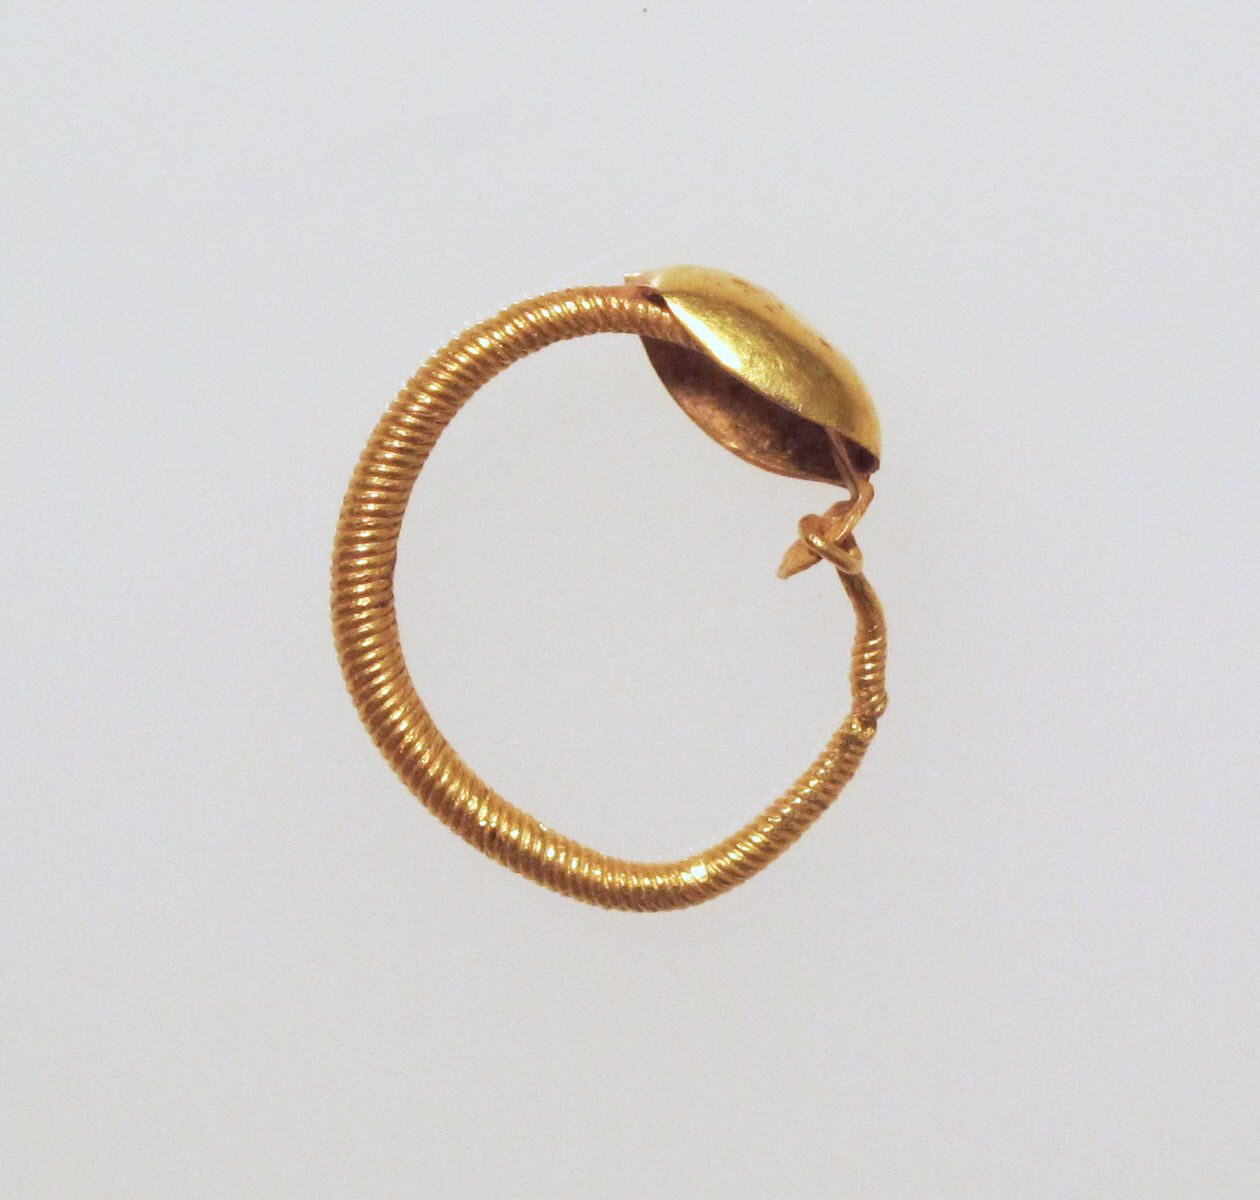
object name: earring with plain loop and disc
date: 7000 BCE-330 CE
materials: gold